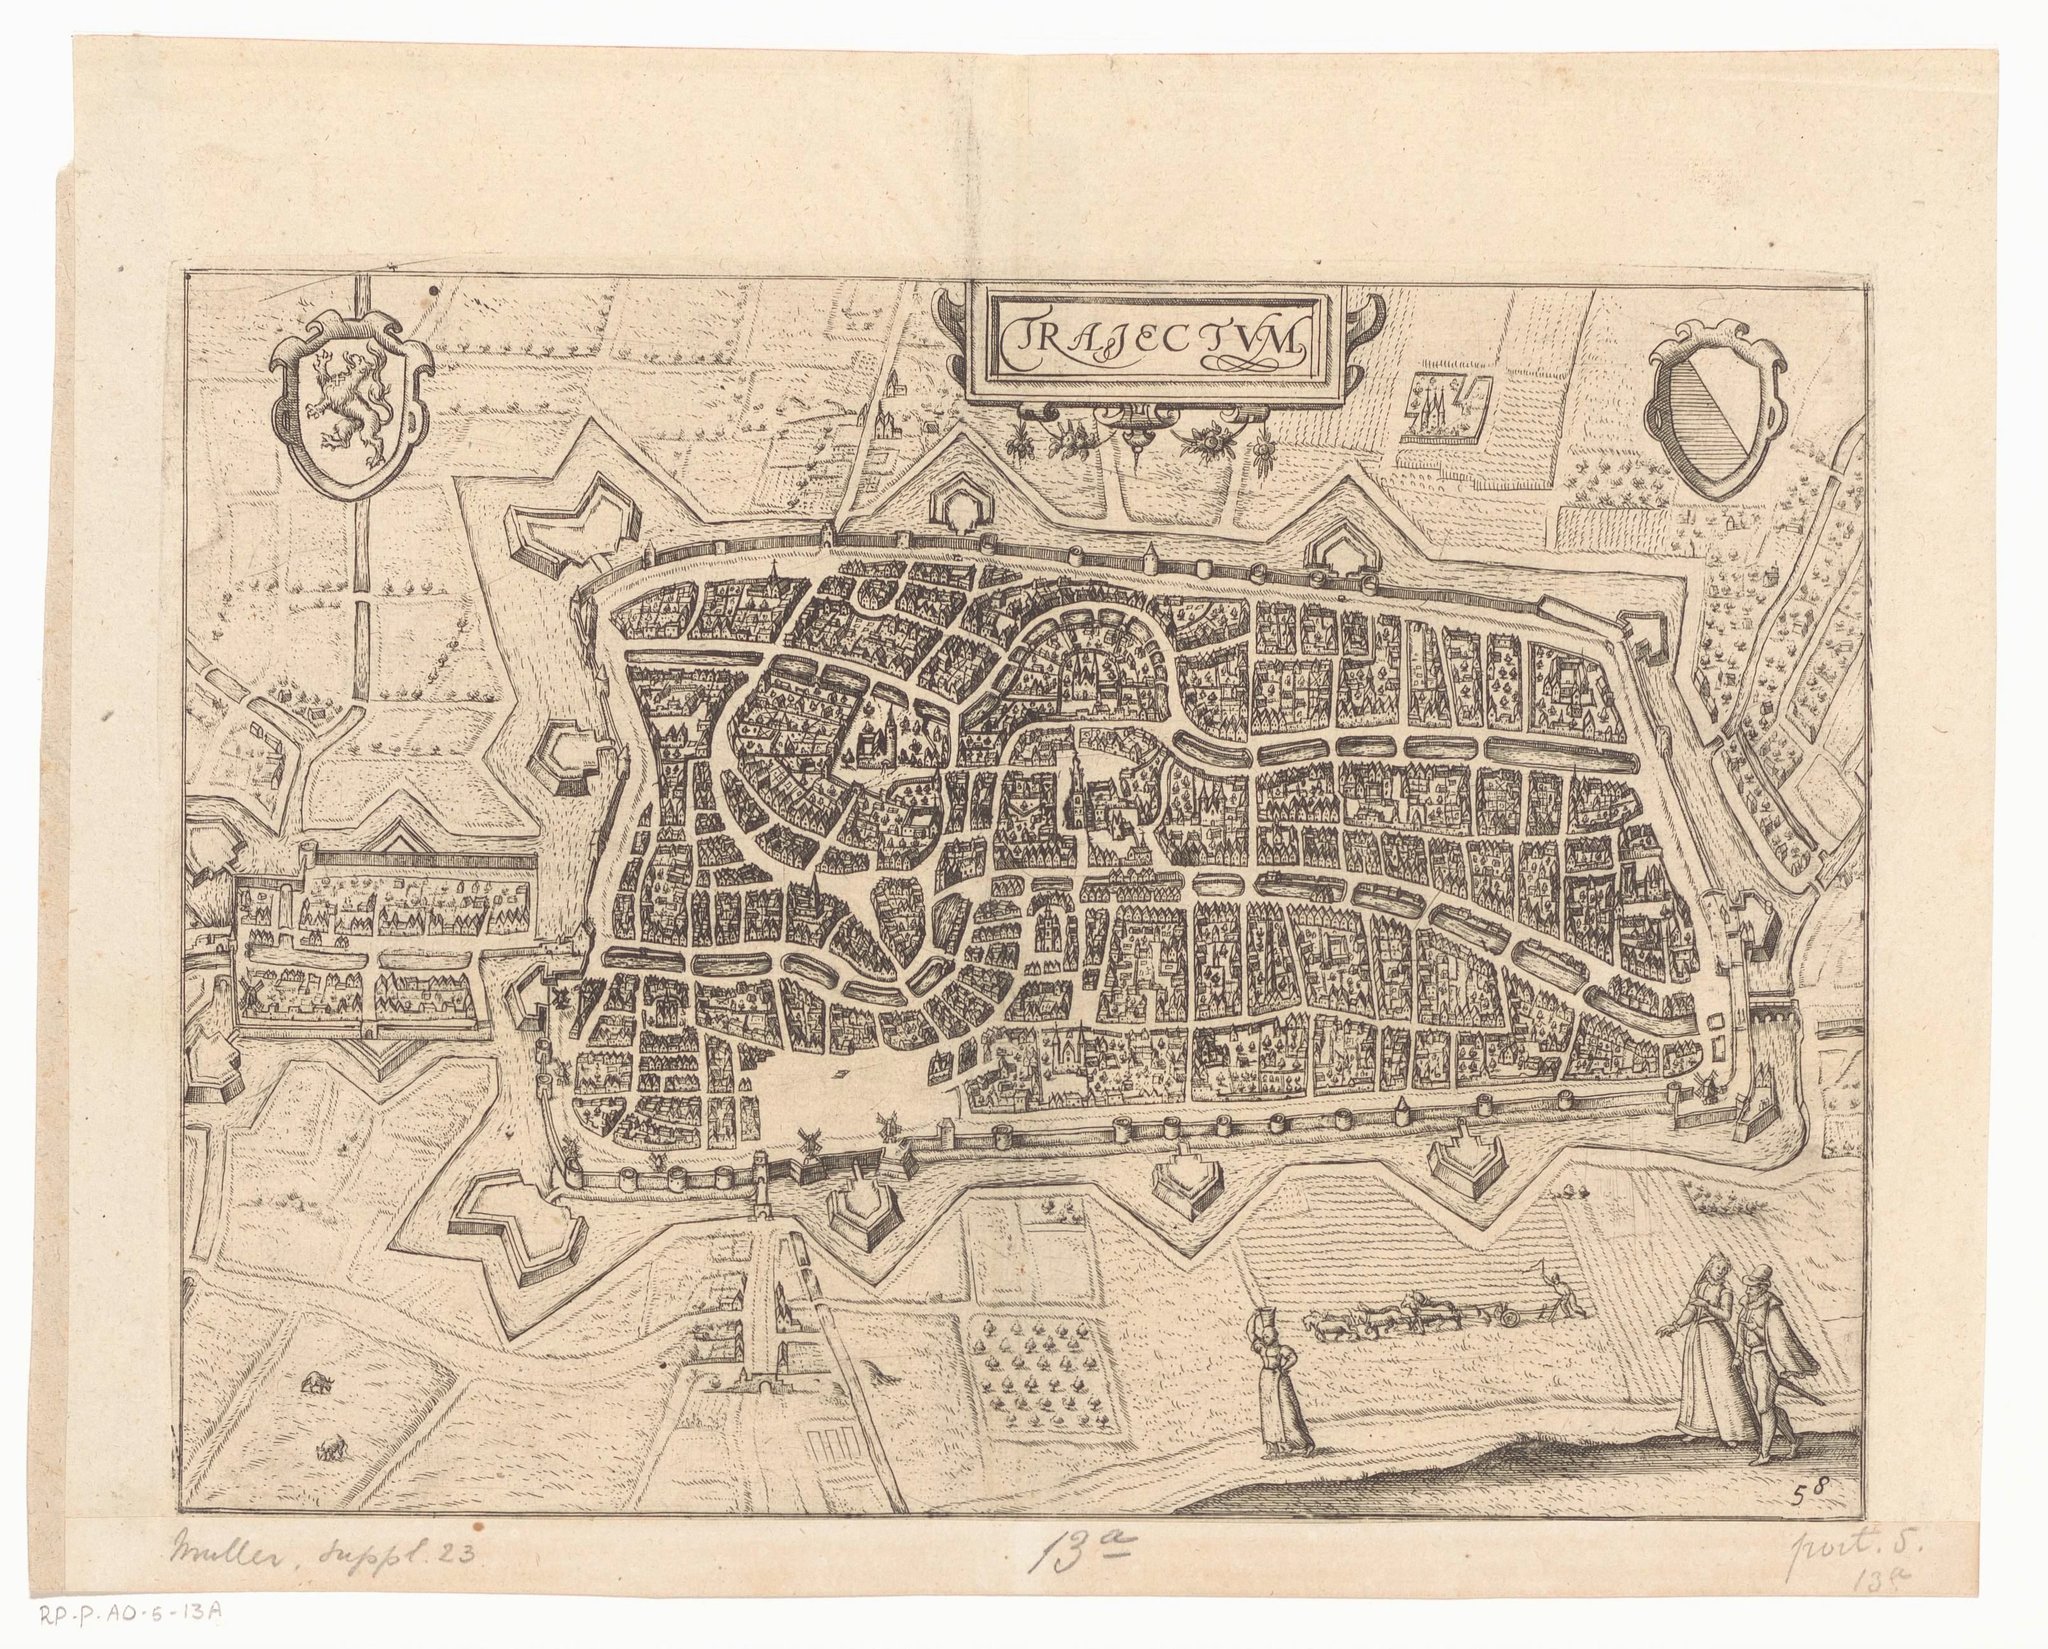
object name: book illustration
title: Plattegrond van de stad Utrecht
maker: Anonymous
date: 1612-1648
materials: paper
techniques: engraving, etching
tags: coat of arms (as symbol of the state, etc.), folk costume, regional costume, maps of cities, utrecht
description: Deze staat van prent voor het eerst ook gebruikt in: Guicciardini, Lodovico. Beschryvinghe van alle de Neder-landen, anderssins ghenoemt Neder-Duytslandt (…). Amsterdam: Willem Janszoon Blaeu, 1612. Hierna is deze prent tot 1648 nog gebruikt in latere uitgaven van deze publicatie, uitgegeven door Blaeu en daarna door Janssonius. Uit welke uitgave het huidige exemplaar precies komt is niet na te gaan.